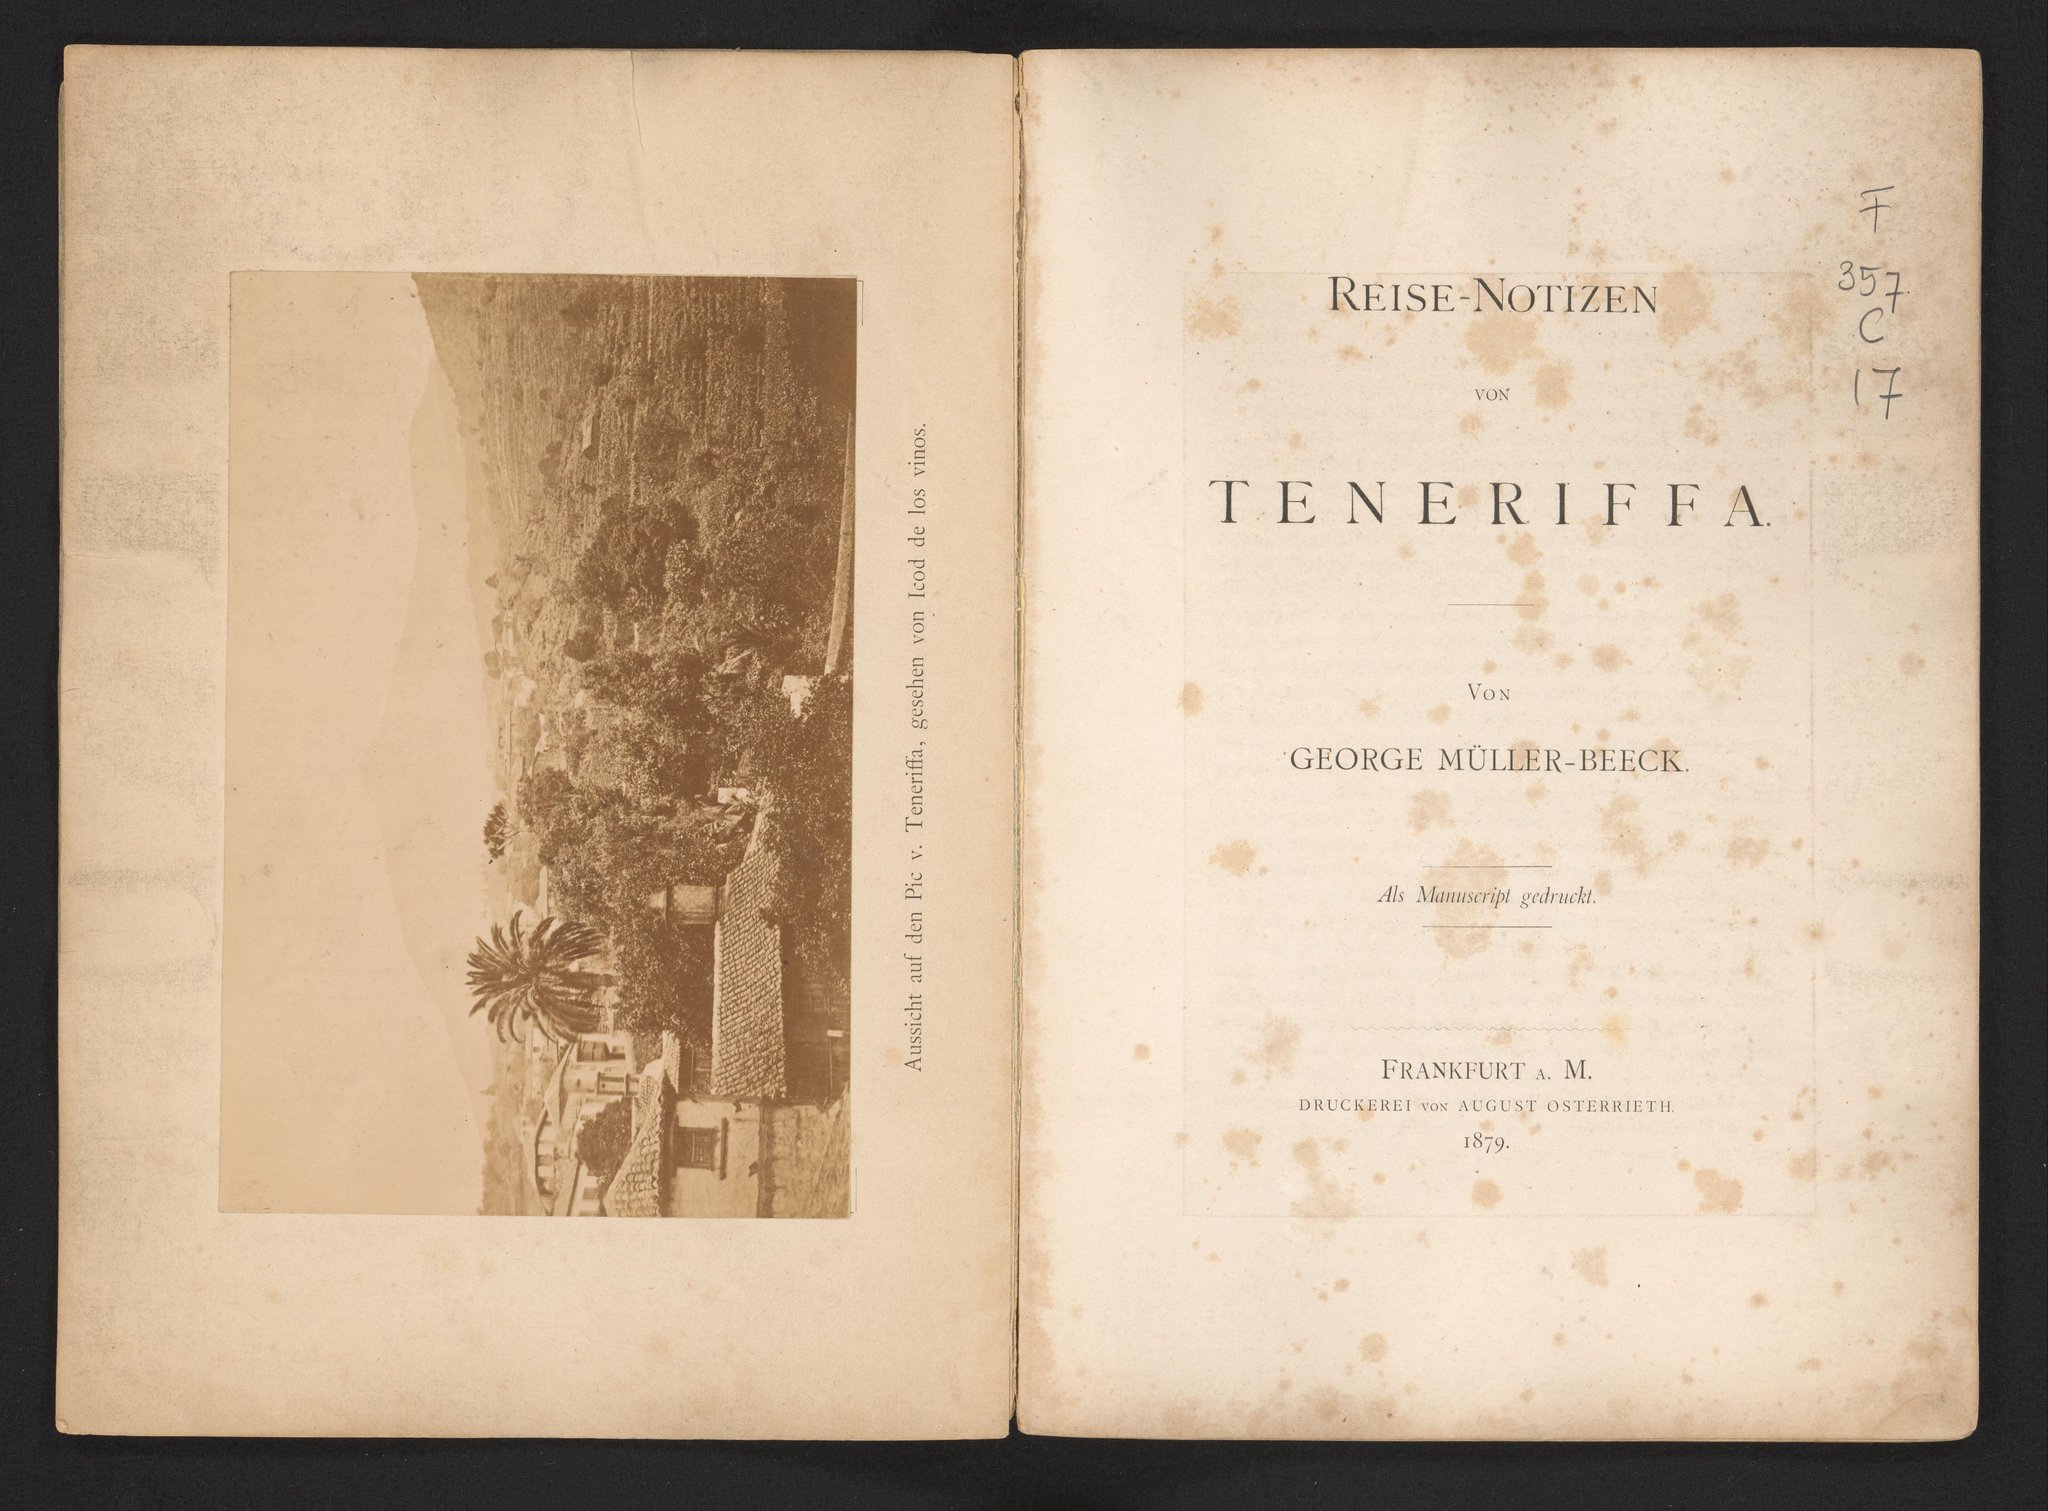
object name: book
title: Reise-Notizen von Teneriffa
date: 1879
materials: cardboard, paper, photographic support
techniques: albumen print, printing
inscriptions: name: ‘W. Junk Verlag u. Buchhandl. f. Naturwiss. u. Mathemat. Berlin N.W.5’